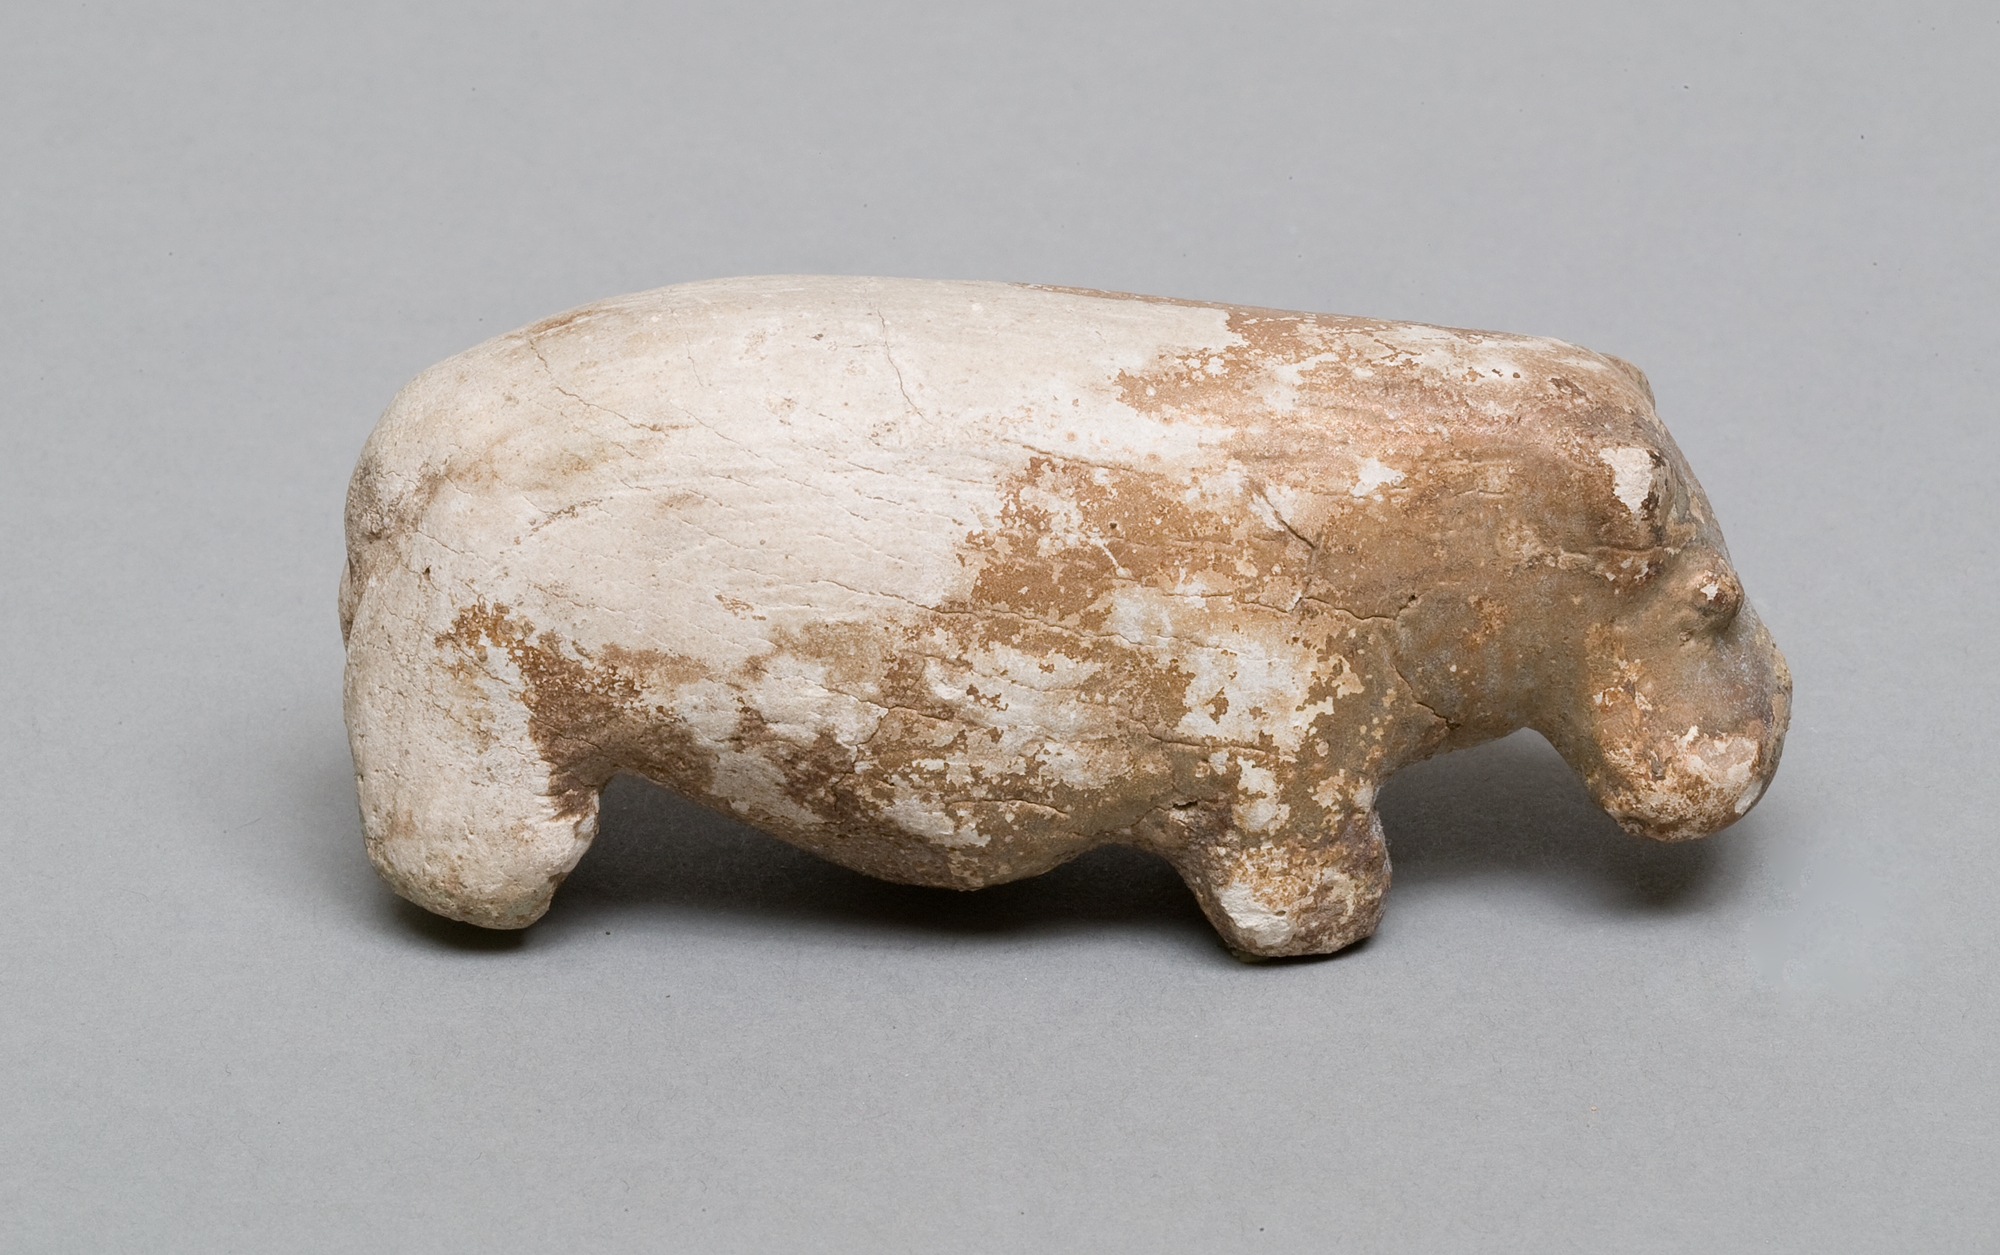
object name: figurine, hippopotamus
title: Hippopotamus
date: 1950-1750 BCE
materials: faience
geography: egypt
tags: hippos